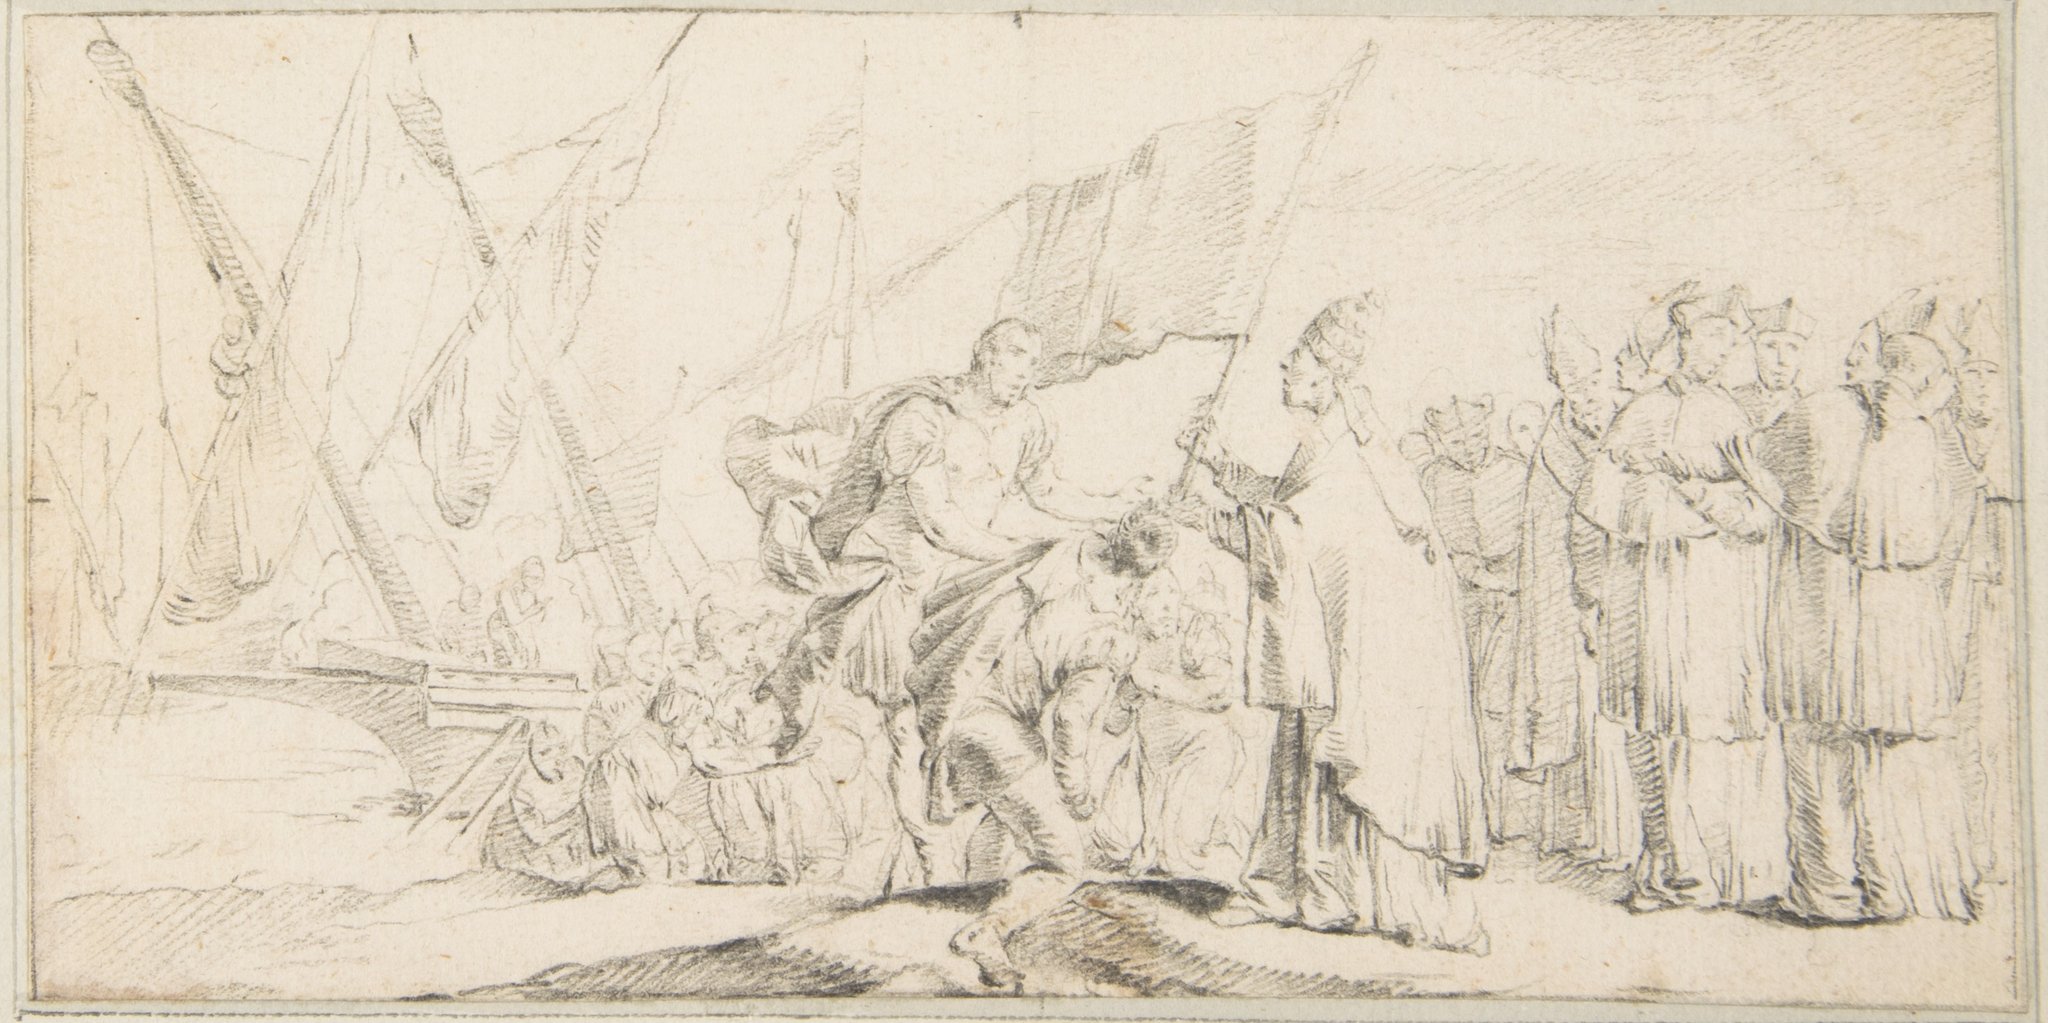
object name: drawing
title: Illustration for a Book: Pope Handing a Banner to a Crusader, with Ships in the Background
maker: giovanni battista tiepolo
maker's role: artist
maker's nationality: italian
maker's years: 1696-1770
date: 1696-1770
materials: chalk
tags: men,popes,flags,ships